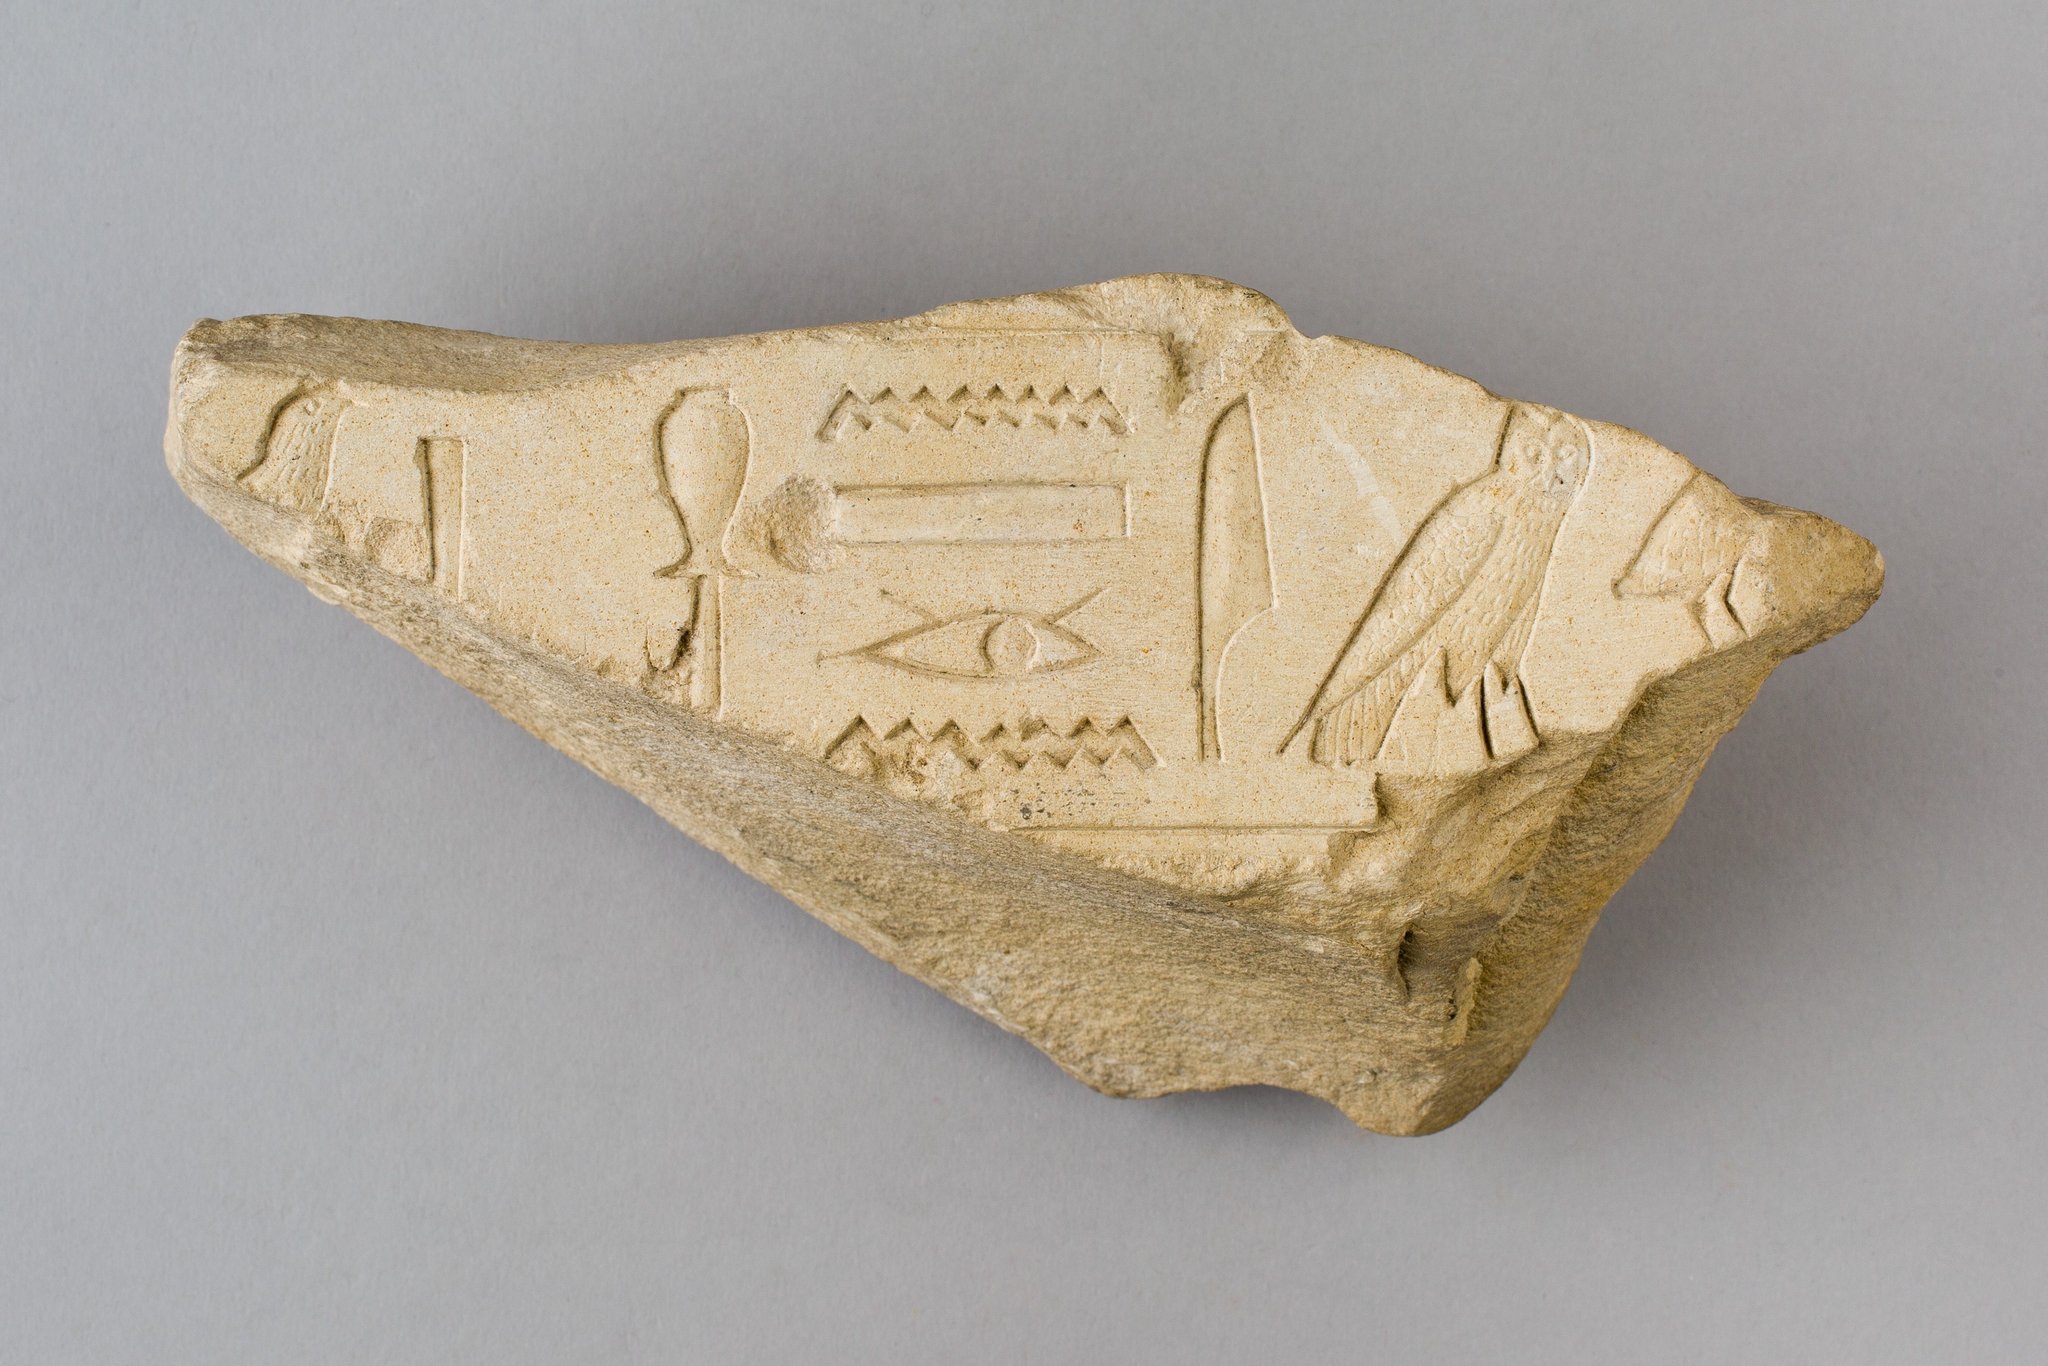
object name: stela, henenu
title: Relief Fragments from the Henenu Stela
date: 2030-2000 BCE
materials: limestone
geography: egypt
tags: hieroglyphs